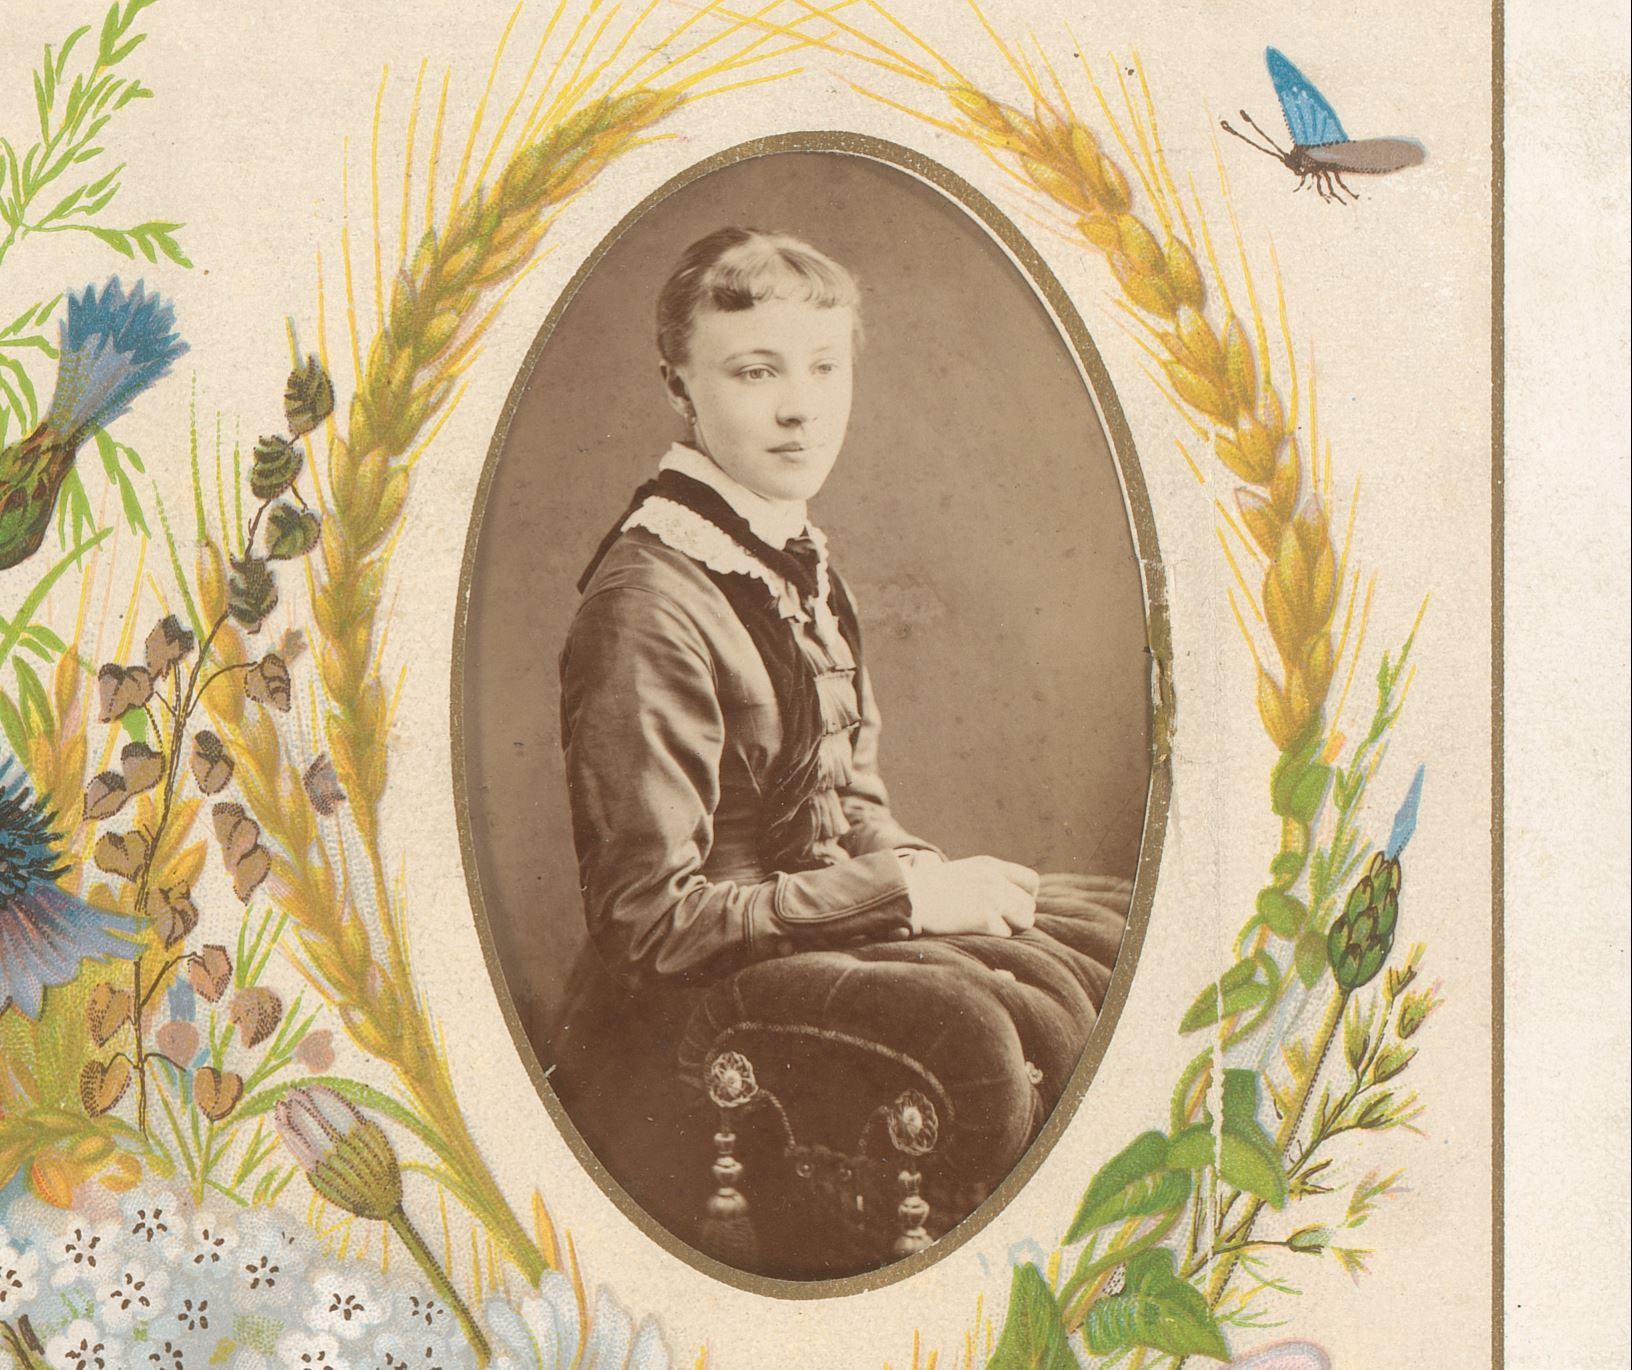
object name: album leaf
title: Portret van een zittende vrouw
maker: Anonymous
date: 1860-1875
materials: cardboard, paper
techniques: albumen print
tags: sitting figure, historical persons - bb - woman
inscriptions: inscription: ‘No....../ S. GOOD./ PHOTOGRAPHER/ SEATON’